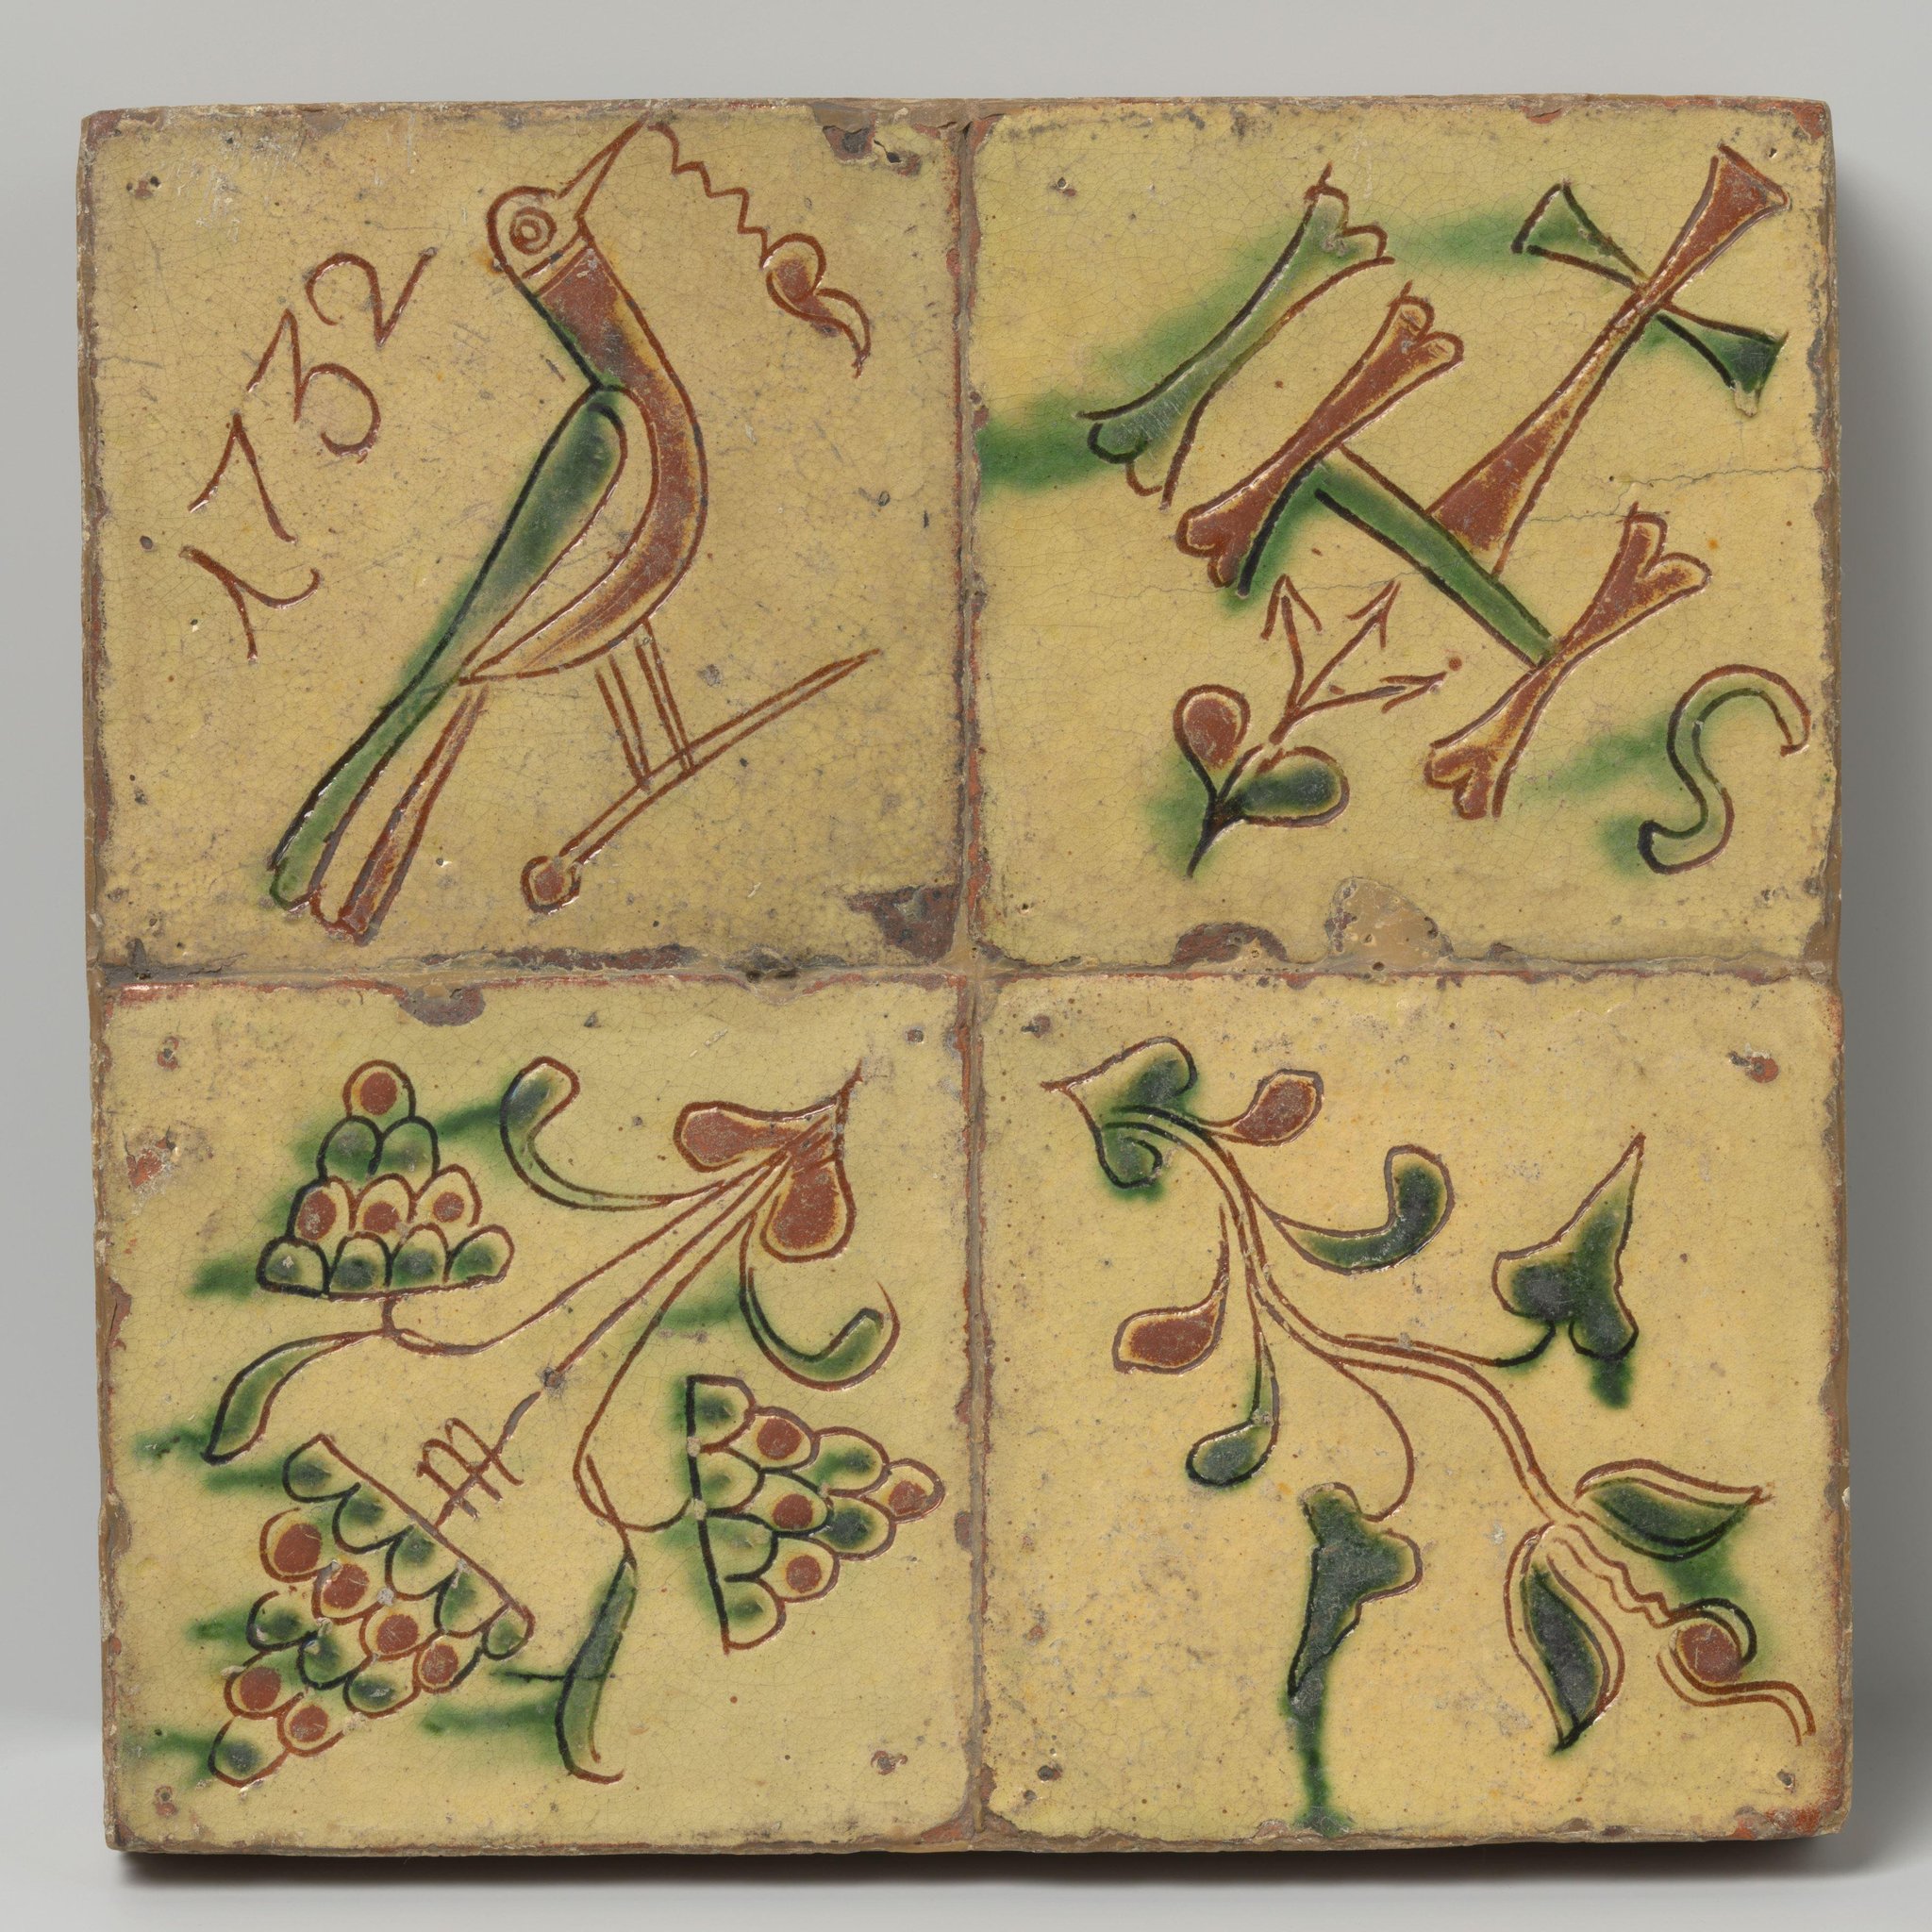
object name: tile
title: Veld van vier tegels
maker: Anonymous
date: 1732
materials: earthenware, glaze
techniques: scoring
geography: roeselare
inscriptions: date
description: Veld van vier tegels (2 x 2) met een vogel en het jaartal 1732, IHS met kruis en bloem, drie druiventrossen aan een tak, en een wingerdrank.